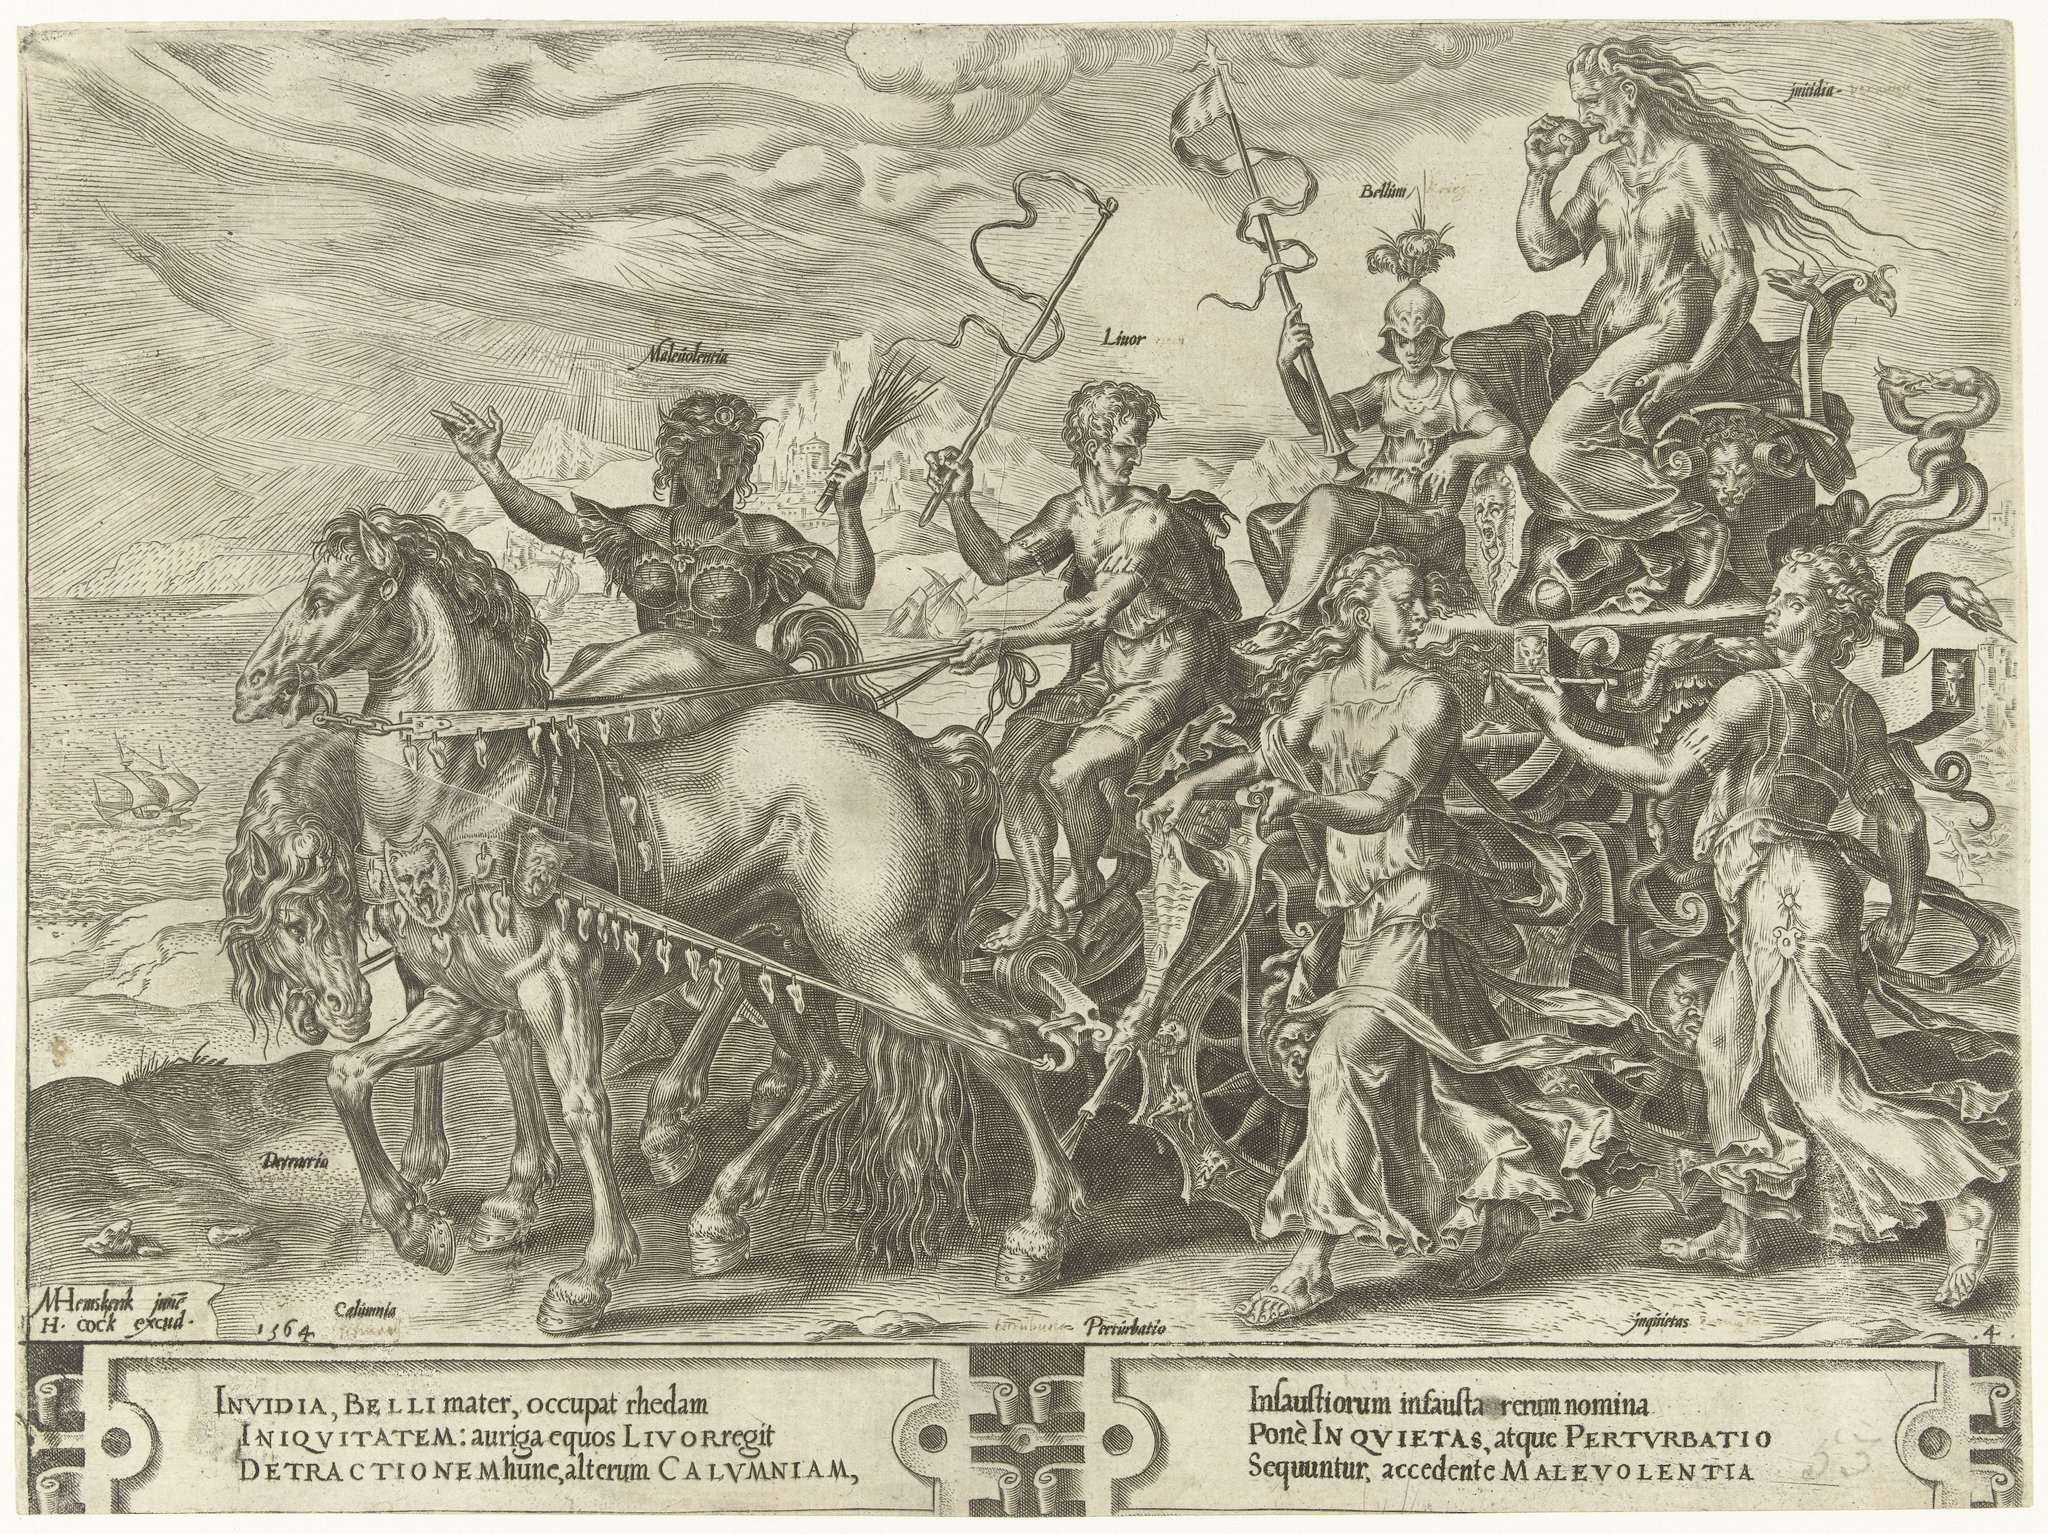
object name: print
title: Triomfwagen met Afgunst (Invidia)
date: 1564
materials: paper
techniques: engraving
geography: antwerp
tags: vicissitudes of life (+ allegorical scene, i.e. two or more personifications involved in an action), envy; 'invidia' (ripa) ~ personification of one of the seven deadly sins - nn - triumph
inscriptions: collector's mark: Lugt 2228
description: De personificatie van afgunst zit op een triomfwagen die rijdt langs de kust. Afgunst heeft een uitgemergeld lichaam en eet van haar hart. De triomfwagen wordt getrokken door twee paarden en bestuurd door een jonge man. Andere ondeugden lopen met de wagen mee. Prent uit een serie van negen prenten met triomfwagens uit de Antwerpse Besnijdenis-ommegang van 1561. De personificaties op de wagens verbeelden samen de kringloop van het menselijk handelen.